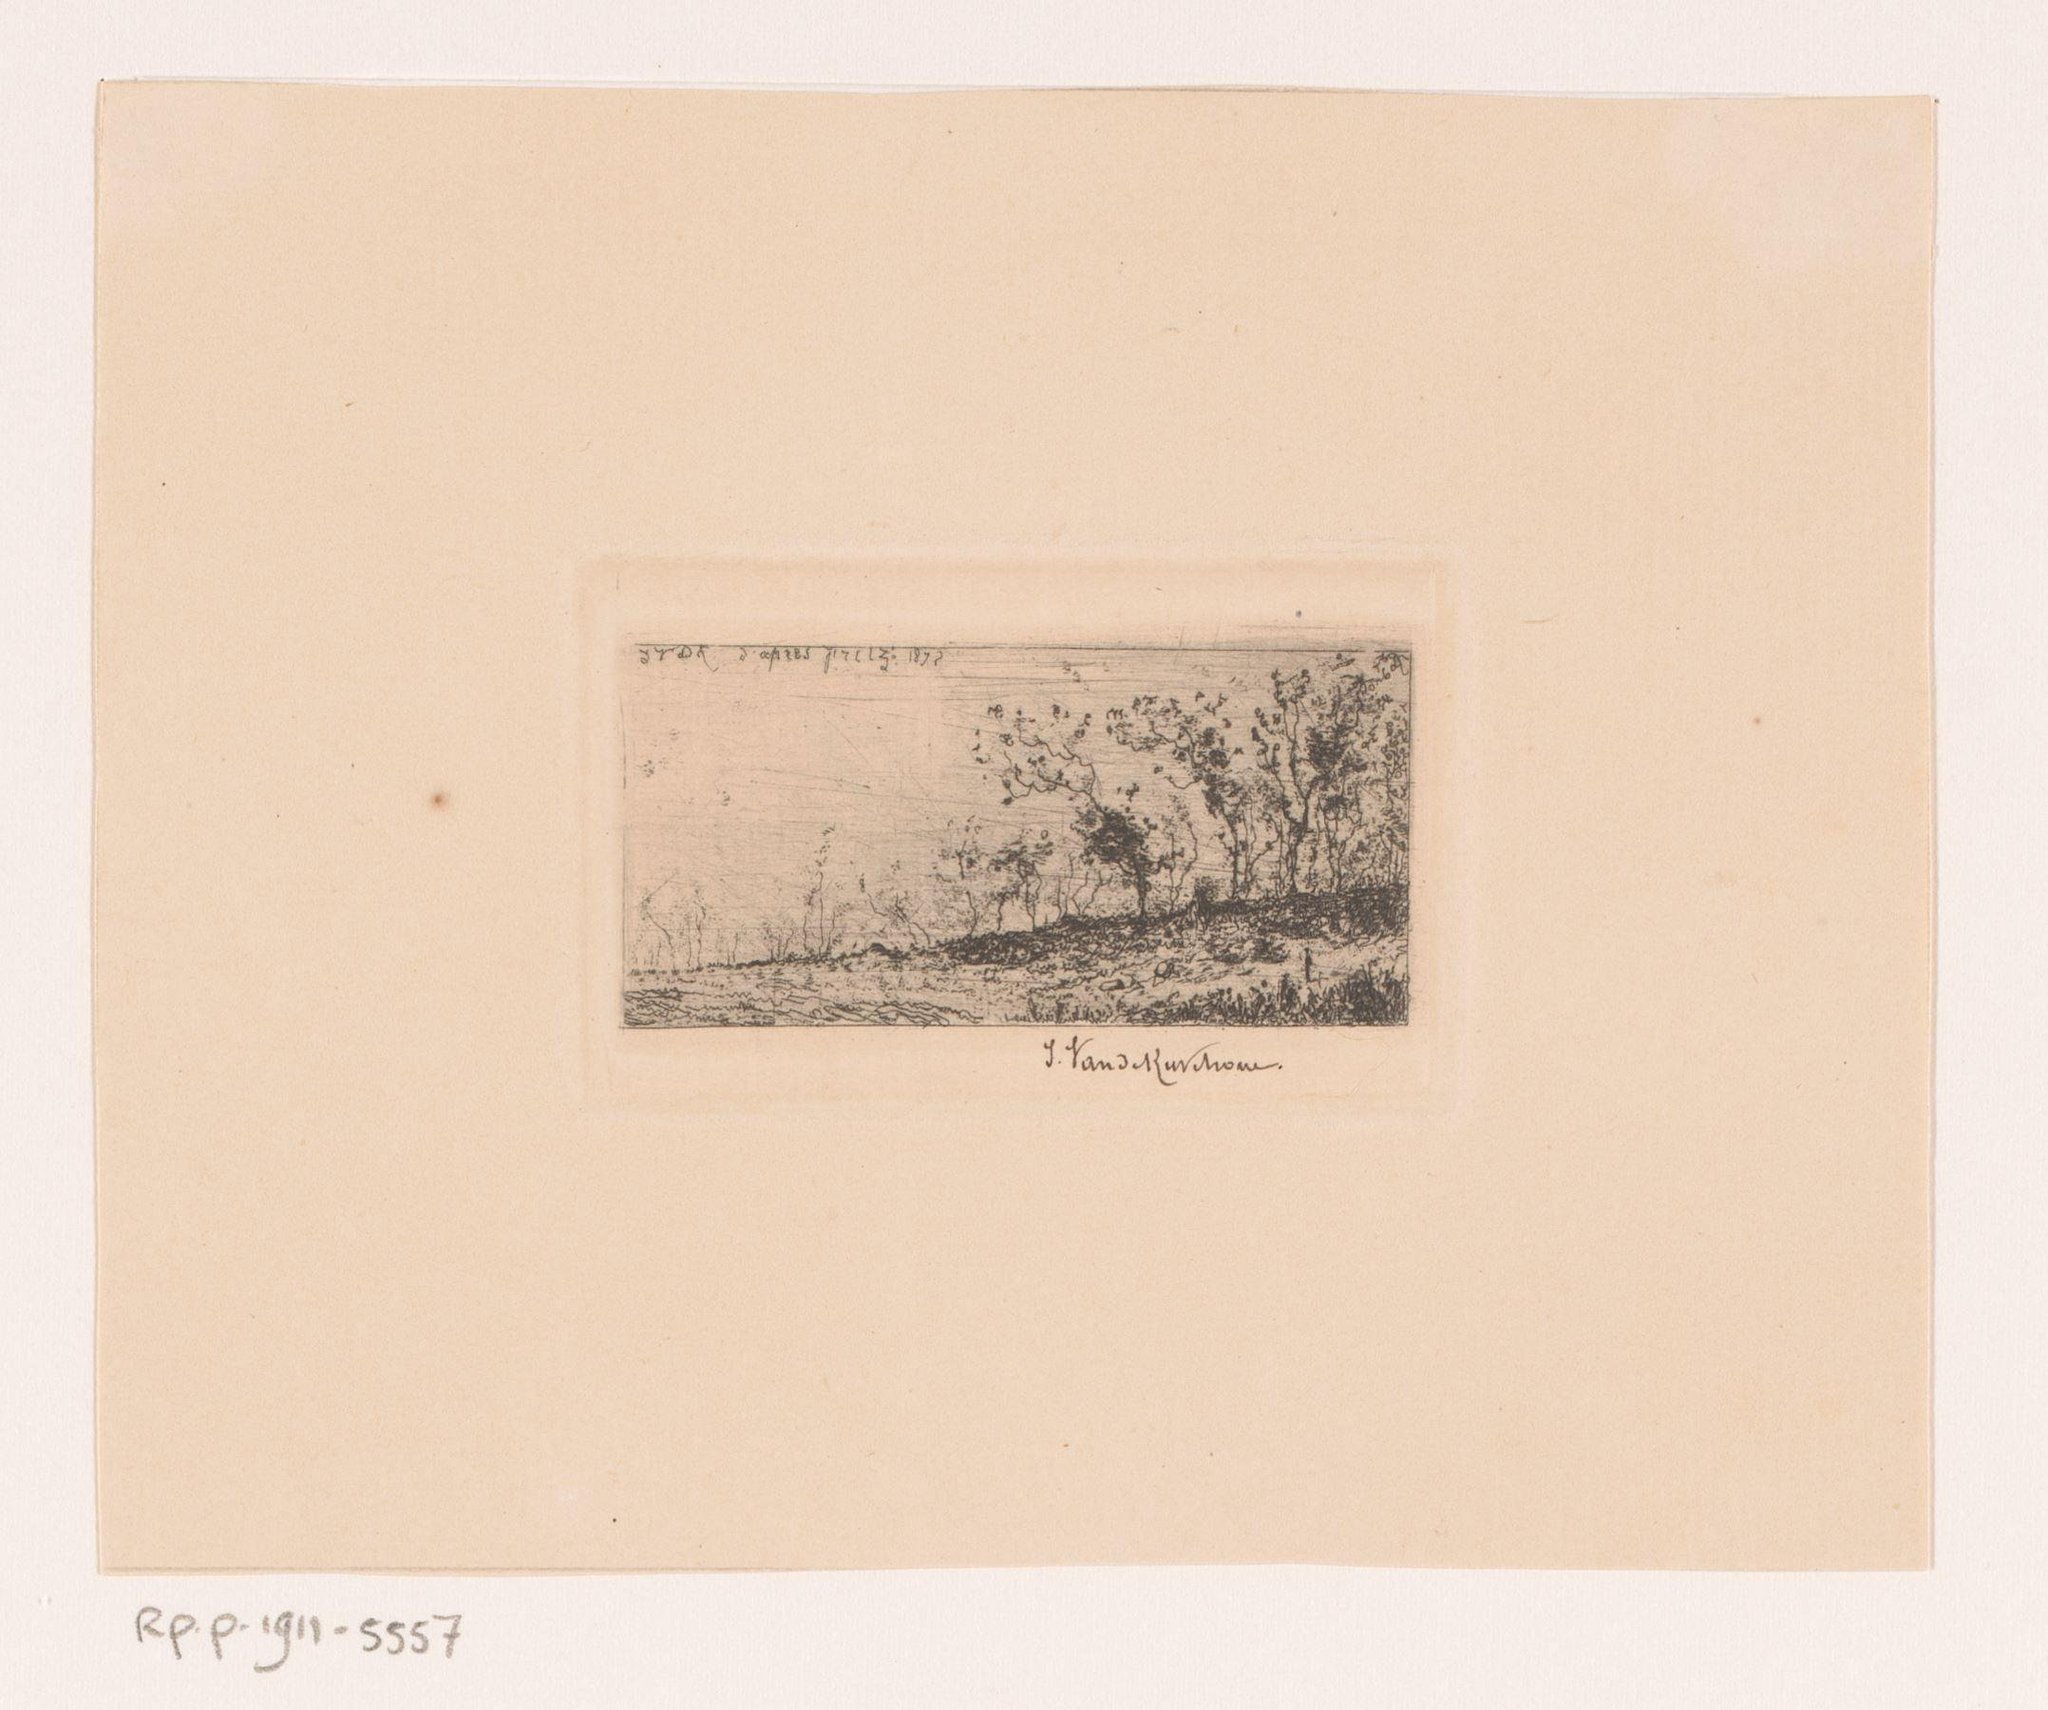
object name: print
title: Landschap met enkele bomen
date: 1873-1881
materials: paper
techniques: drypoint, etching, intaglio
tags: landscapes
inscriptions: collector's mark: Lugt 2228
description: De etsen naar de schilderijen van Frédéric Van de Kerkhove werden na zijn dood door zijn vader en zuster gemaakt en uitgegeven in twee reeksen. De eerste werd in 1877 uitgegeven door het Journal des Beaux-Arts et de la Littérature: Cahier de 25 Eaux-fortes d'après Frédéric van de Kerkhove, gravées par son père et sa sœur. De tweede reeks van 126 etsen, ook in 1877, werd in Parijs uitgegeven bij A. Lévy onder de titel Cent eaux-fortes gravées par J. Van de Kerkhove d'après les tableaux de Frédéric Van de Kerkhove, mort en 1873 à l'âge de 10 ans et 11 mois.